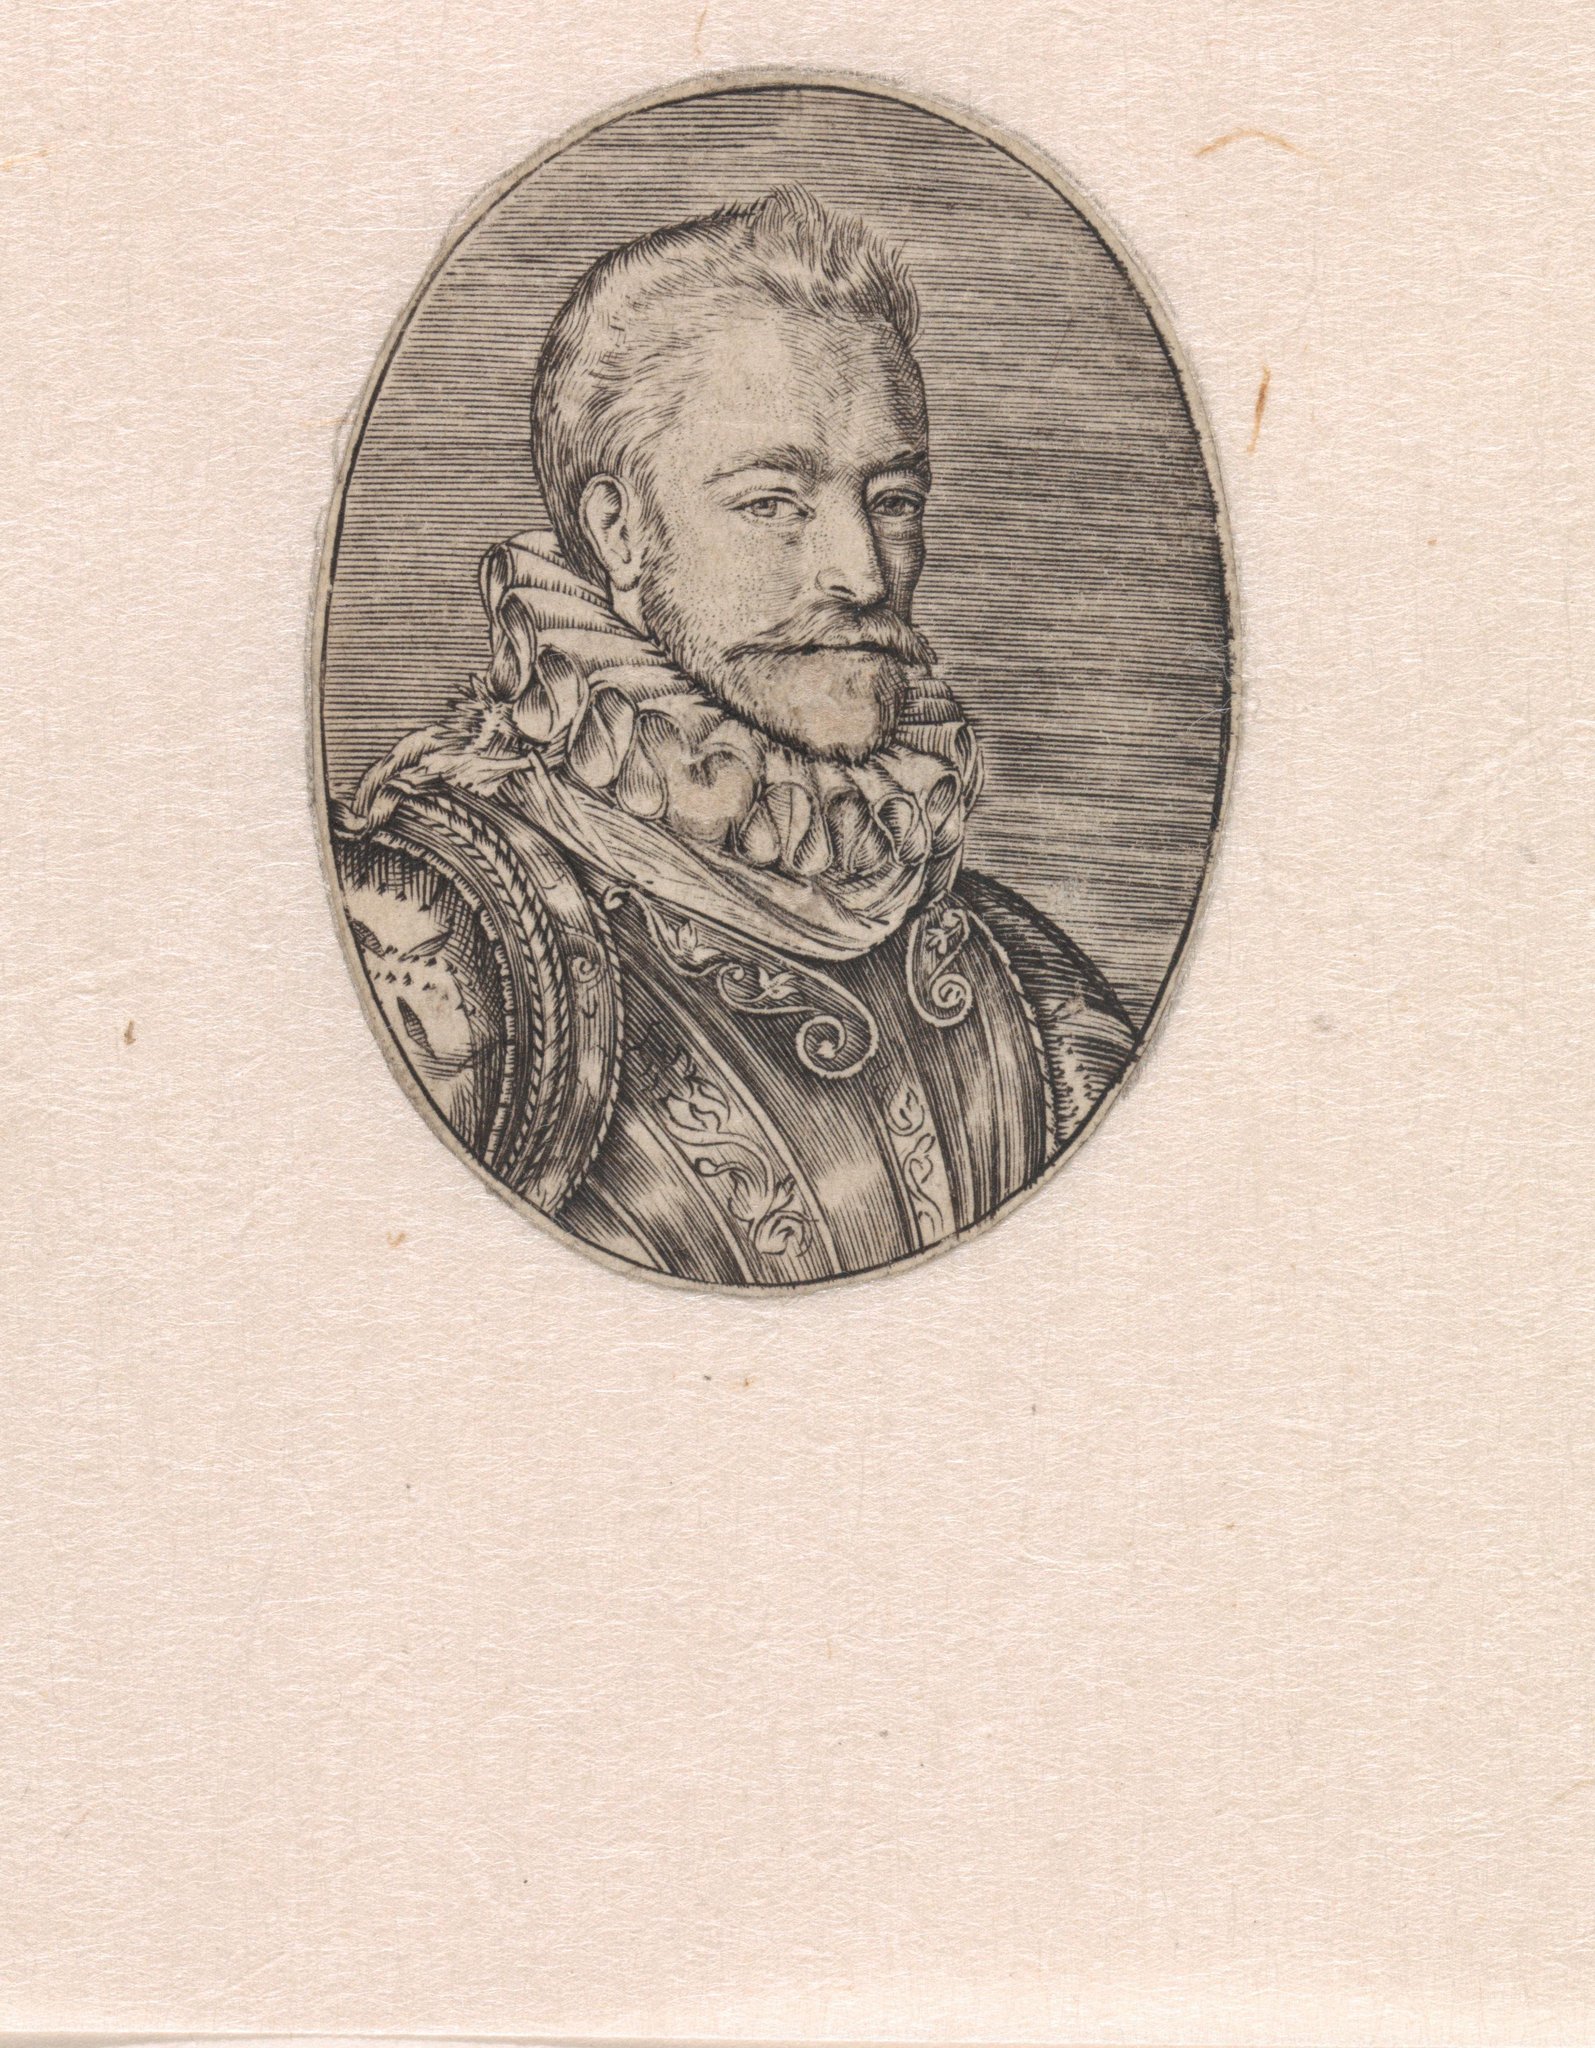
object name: print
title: Portret van Jacques de la Faille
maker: Anonymous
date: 1580-1667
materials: paper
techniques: engraving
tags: militair, koopman, jacques de la faille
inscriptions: collector's mark: Lugt 2228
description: Portret van koopman Jacques de la Faille. Hij vluchtte in 1584 uit Antwerpen naar Haarlem.